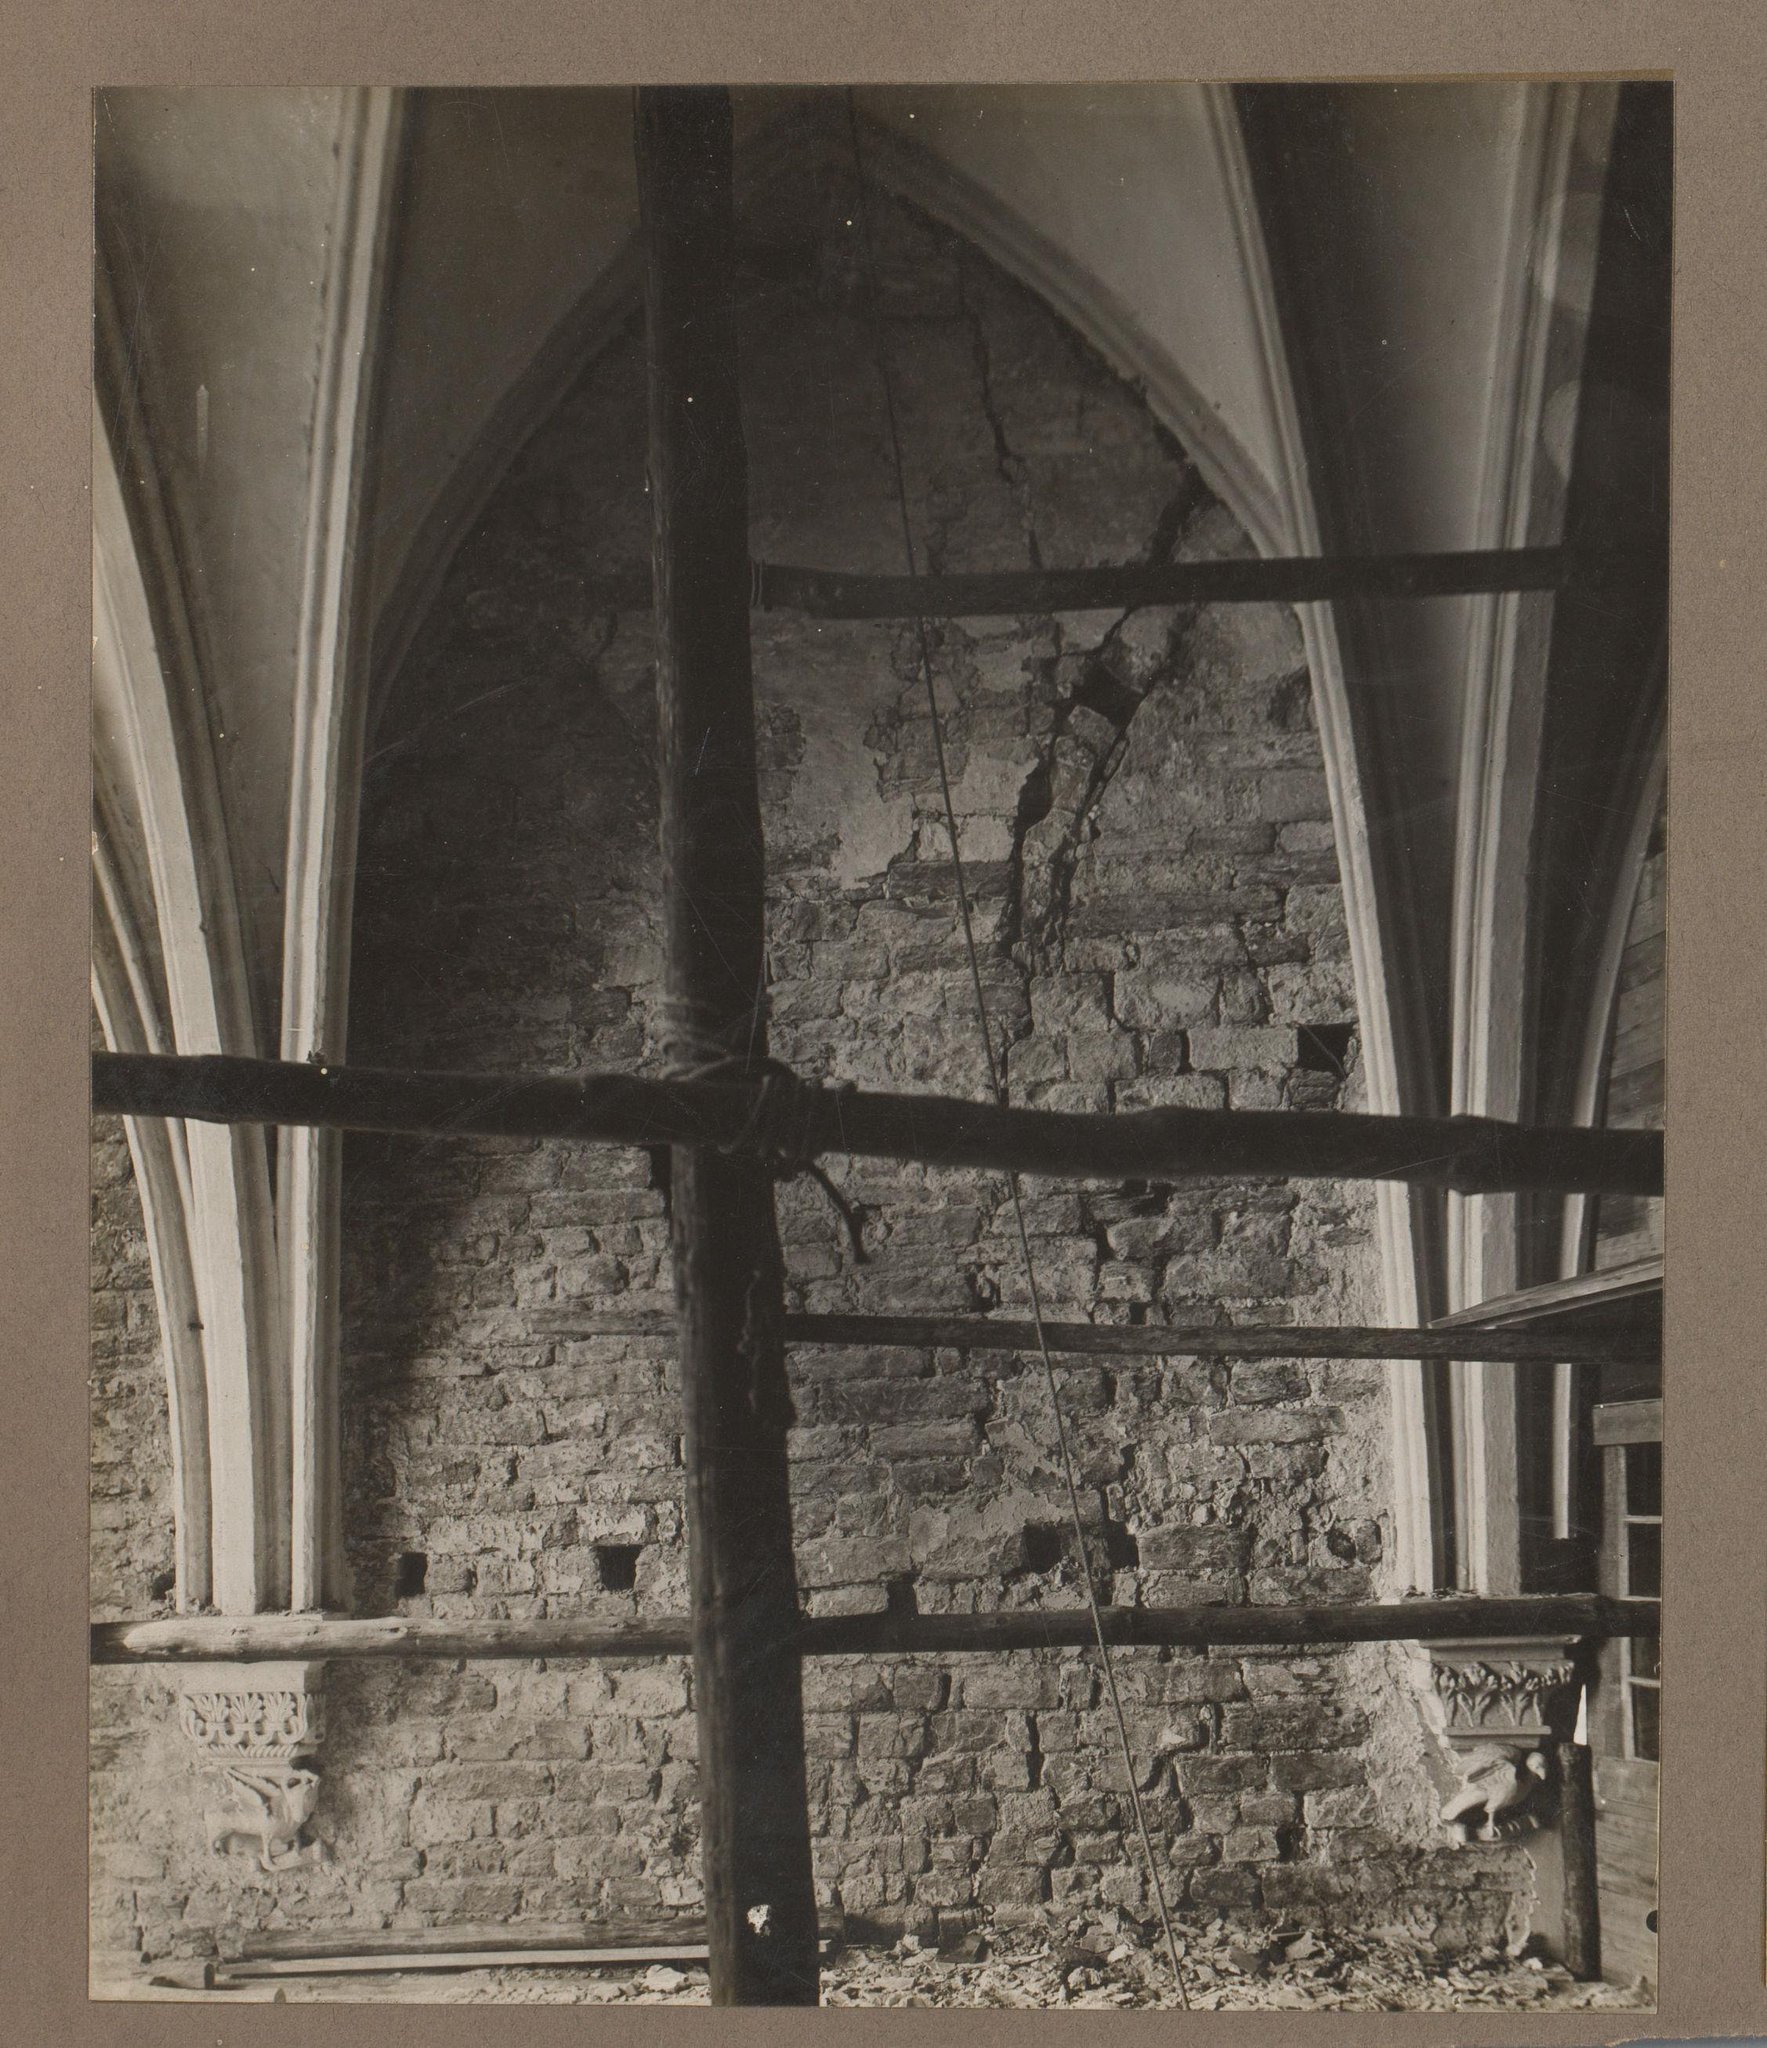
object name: photograph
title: Gestut gewelf dat aan het instorten is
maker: Anonymous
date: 1880-1920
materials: photographic support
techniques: gelatin silver print